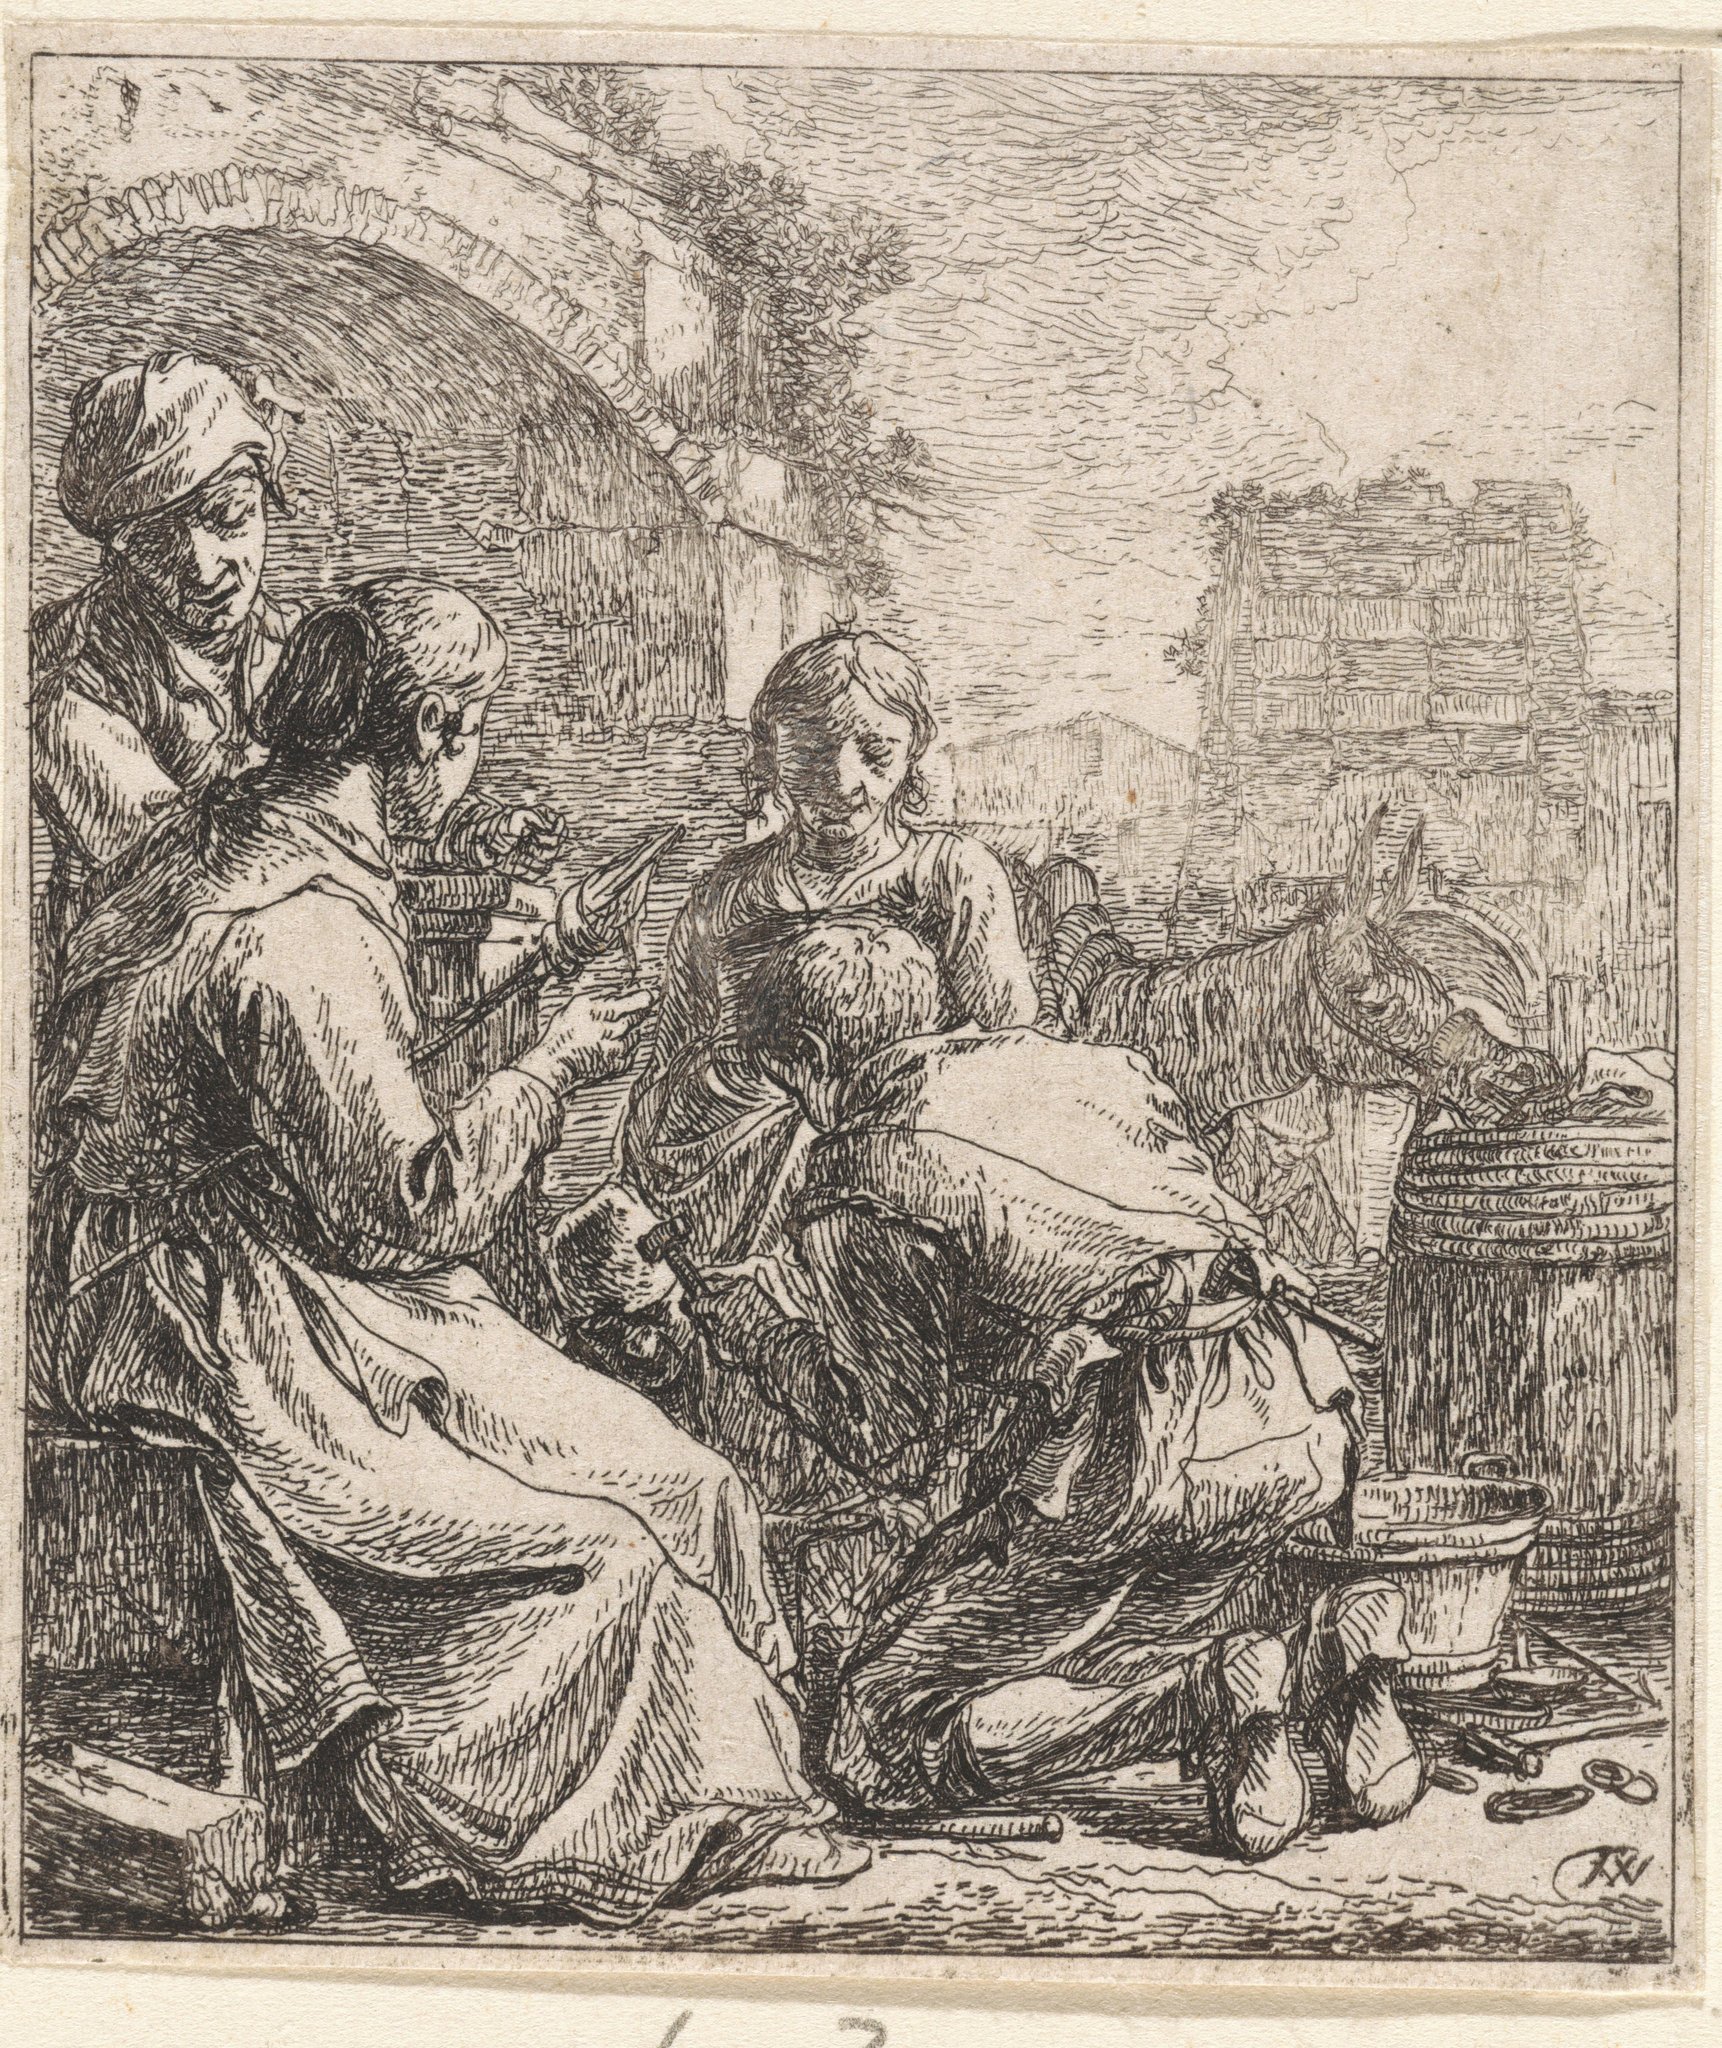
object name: print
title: Spinster en hoefsmid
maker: thomas wijck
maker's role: draughtsman, painter, print maker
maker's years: 1616-1677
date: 1626-1677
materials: paper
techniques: etching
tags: ass, donkey, smith, blacksmith, spinning (manufacture of yarn)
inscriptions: collector's mark: Lugt 240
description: Een man is een ijzer aan het smeden. Links zit een spinnende vrouw. Een man en een vrouw kijken toe. Op de achtergrond een ezel.